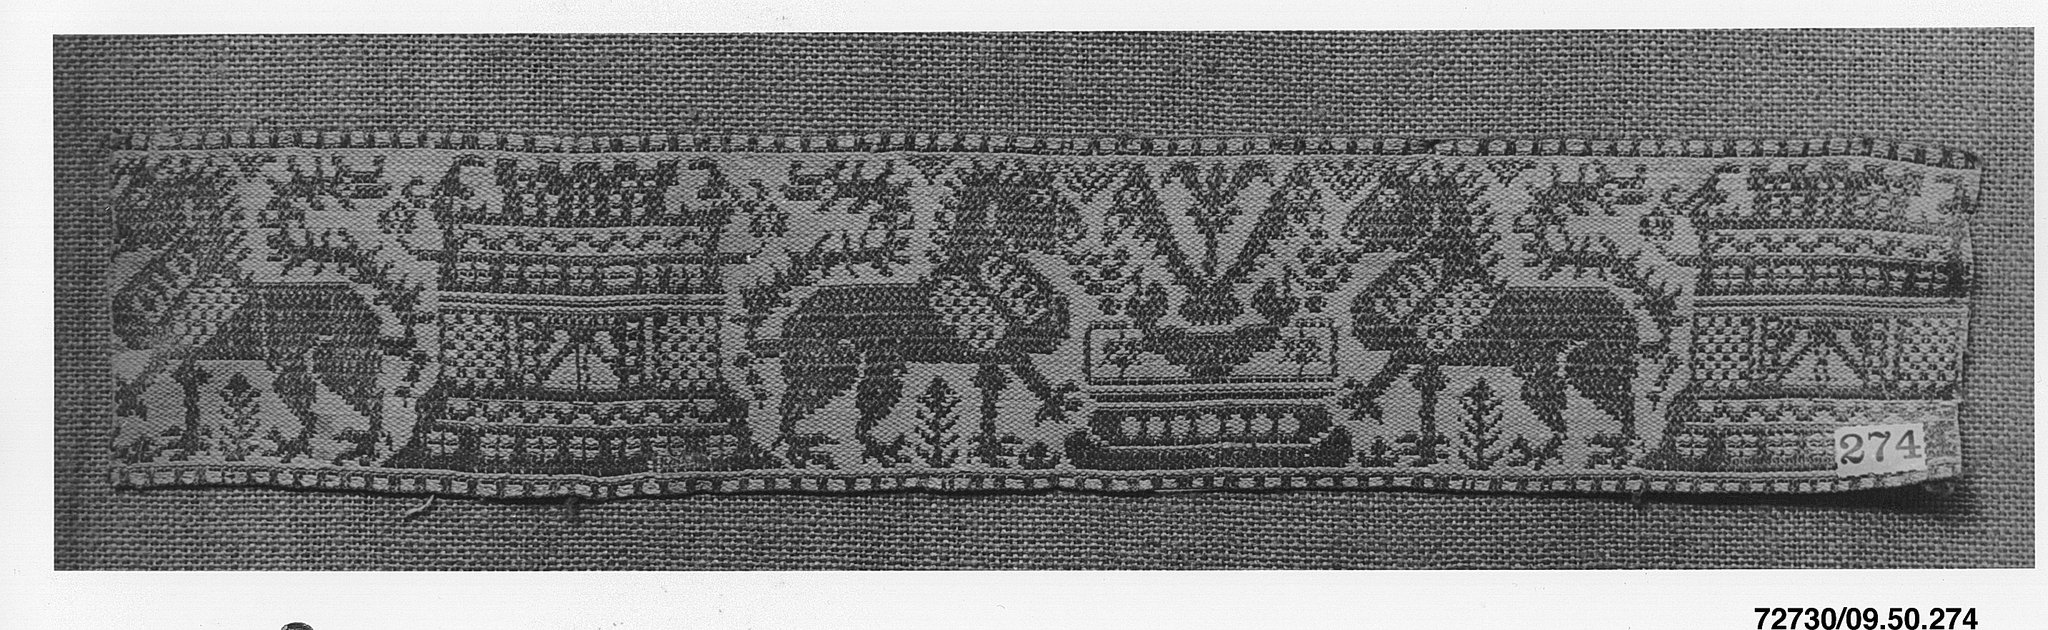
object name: band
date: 1501-1600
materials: linen, silk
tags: mythical creatures